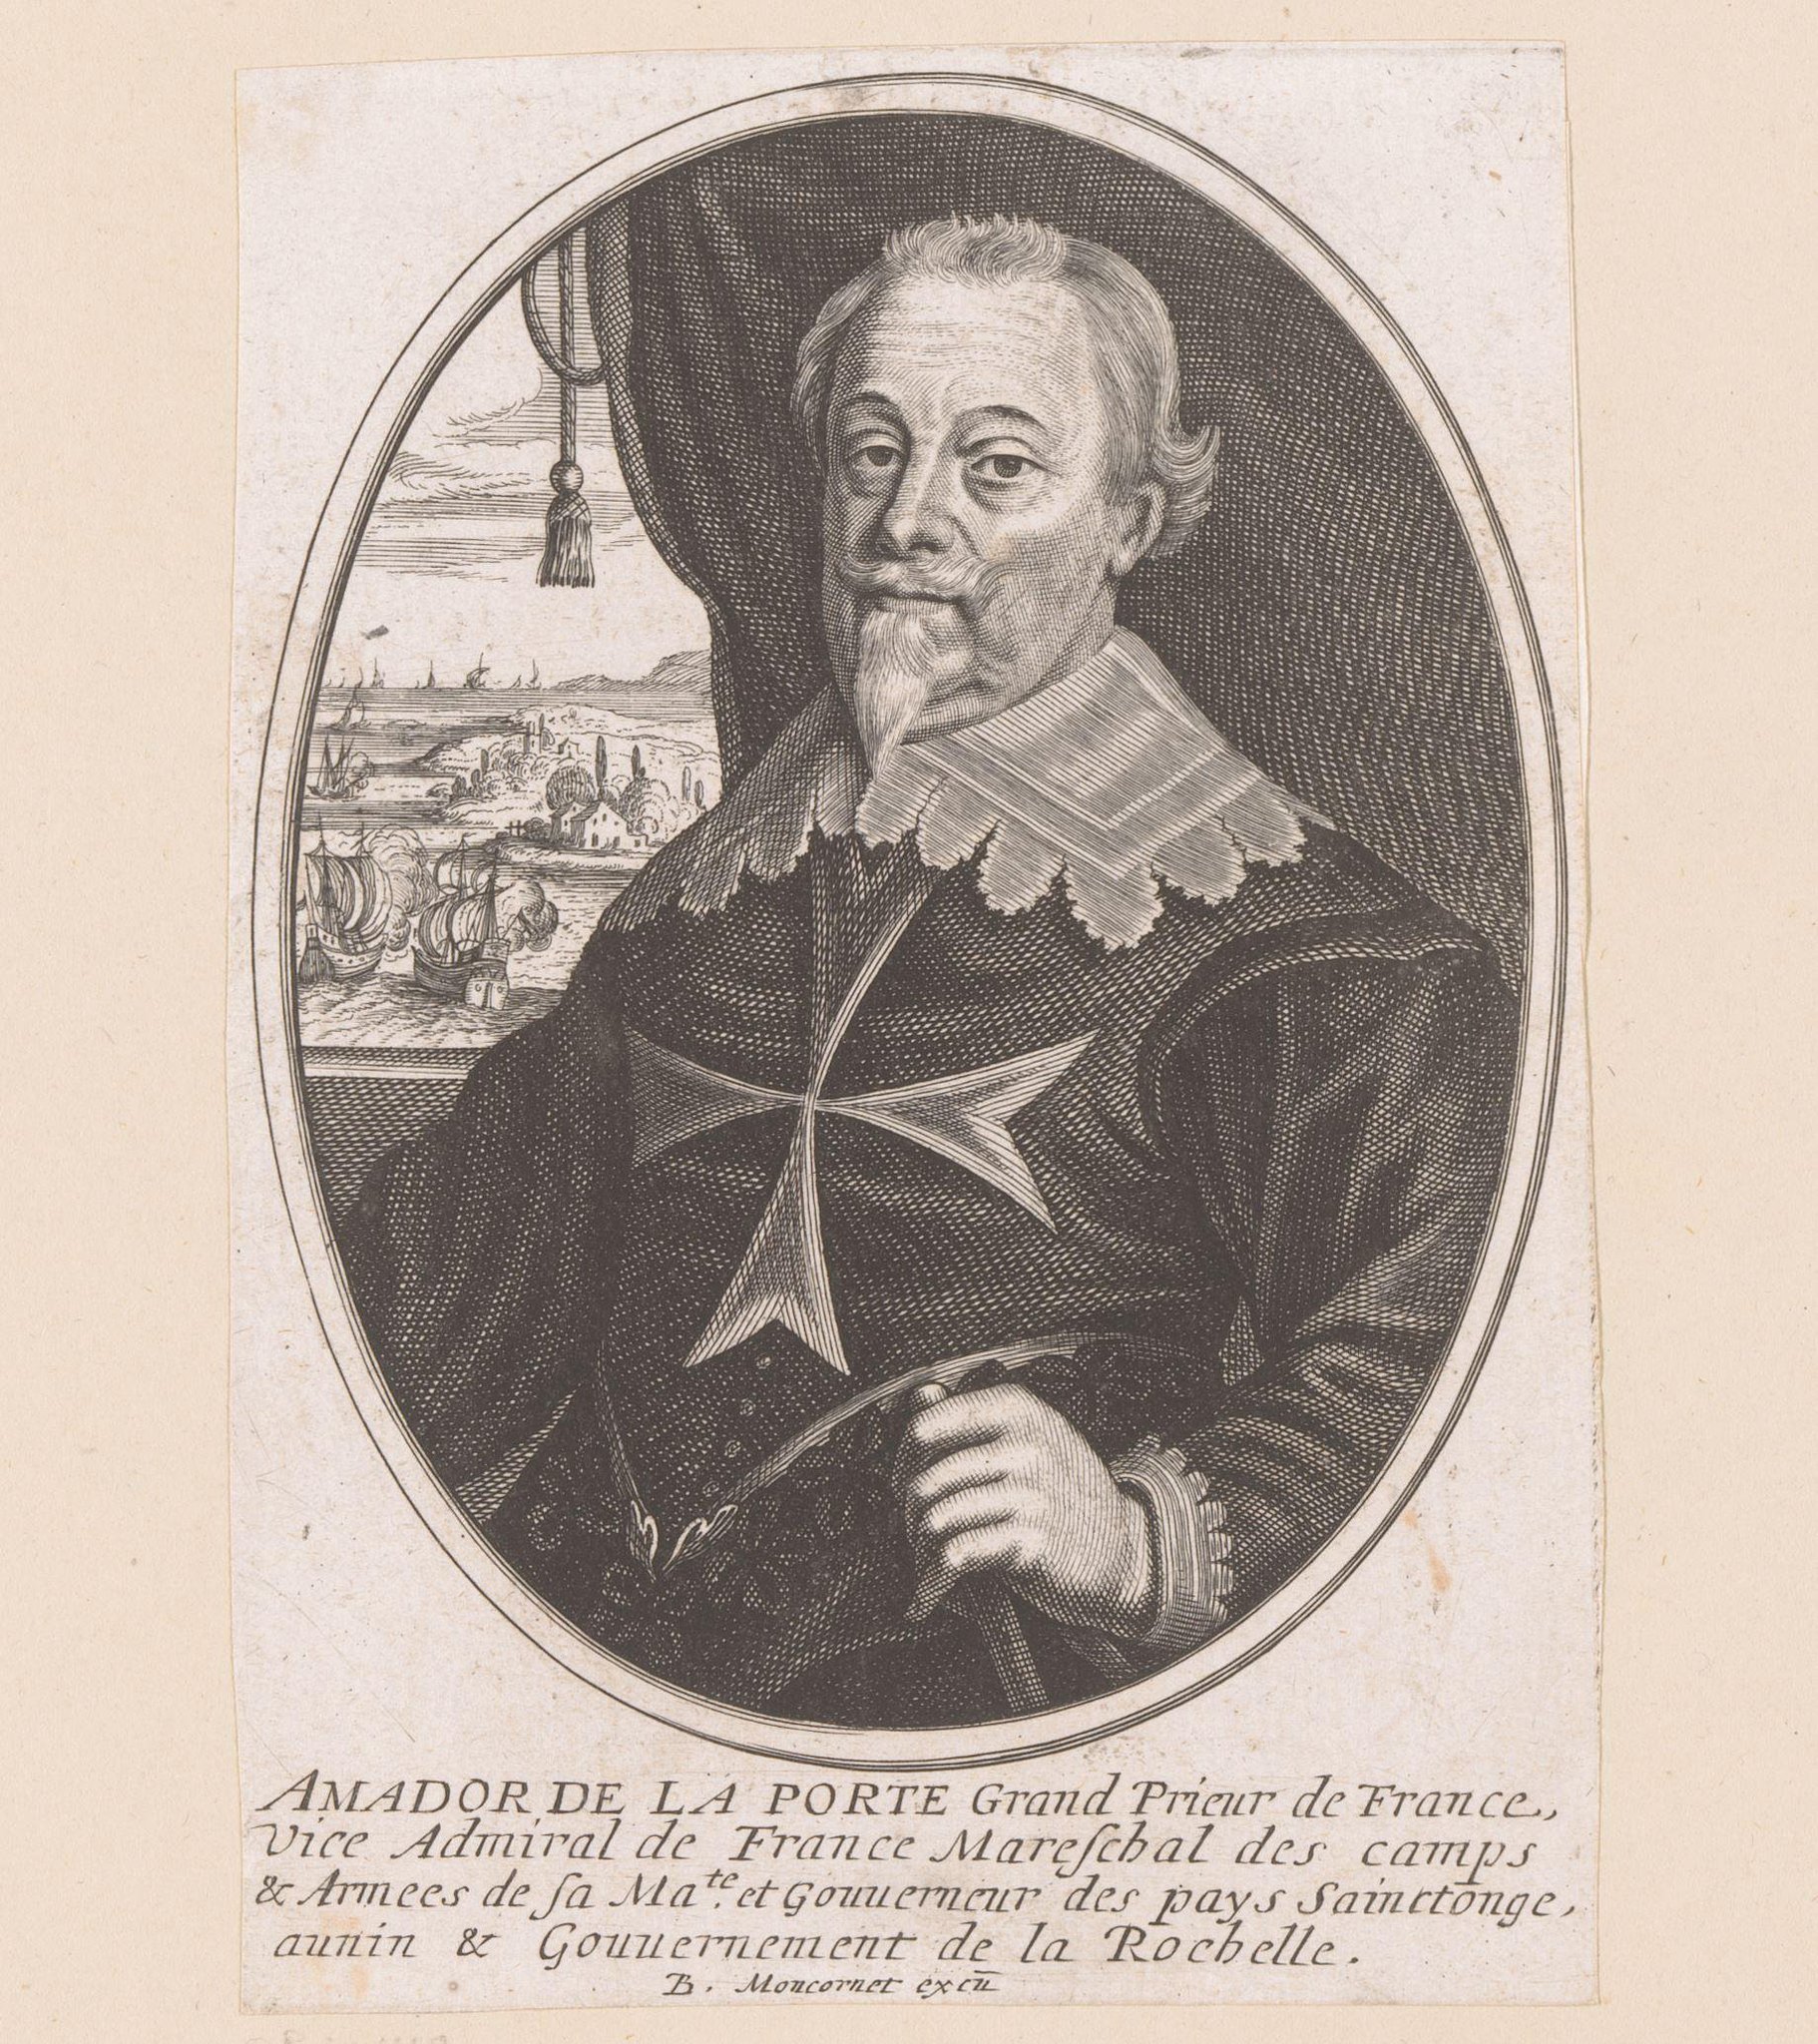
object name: print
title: Portret van Amador de la Porte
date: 1610-1668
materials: paper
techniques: engraving, etching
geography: paris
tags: paris, historical persons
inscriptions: collector's mark: Lugt 240